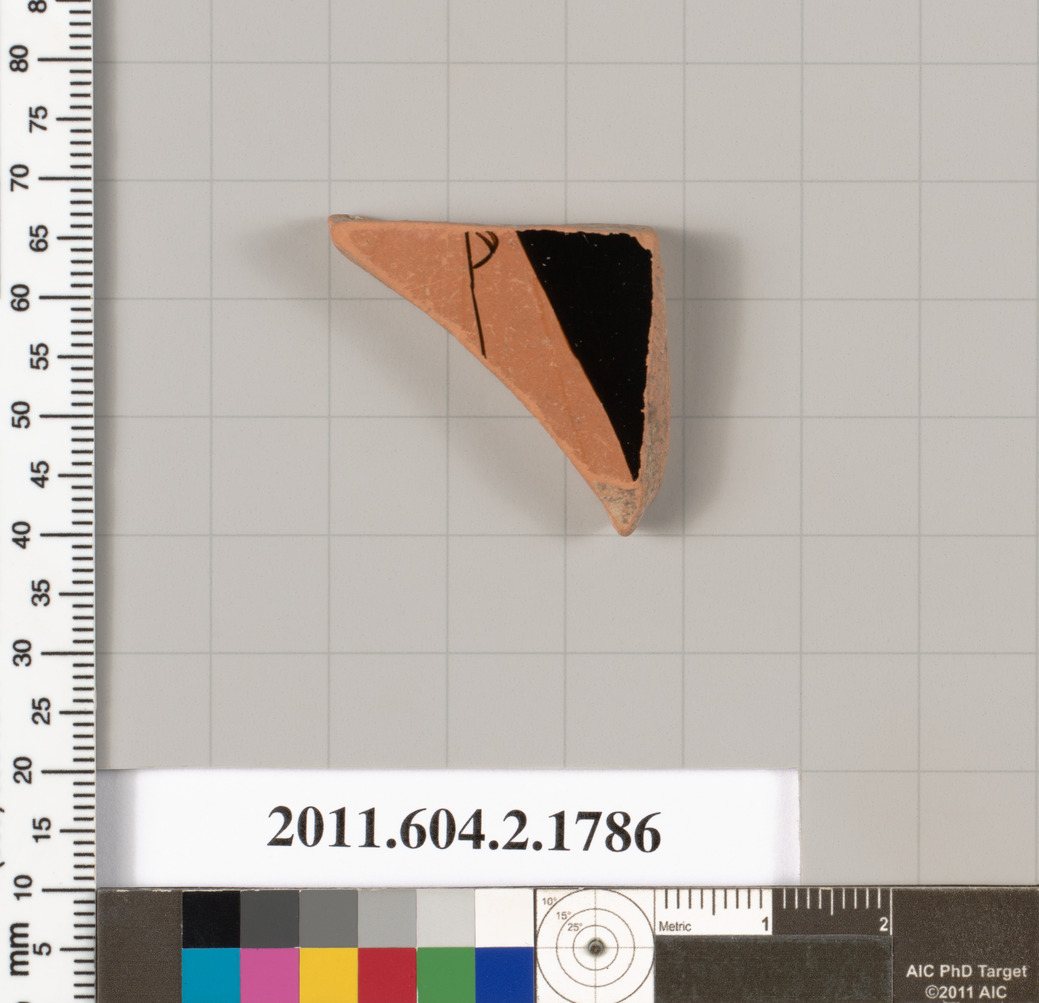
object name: skyphos fragment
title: Terracotta fragment of a skyphos (deep drinking cup)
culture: greek, attic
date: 475-451 BCE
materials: terracotta